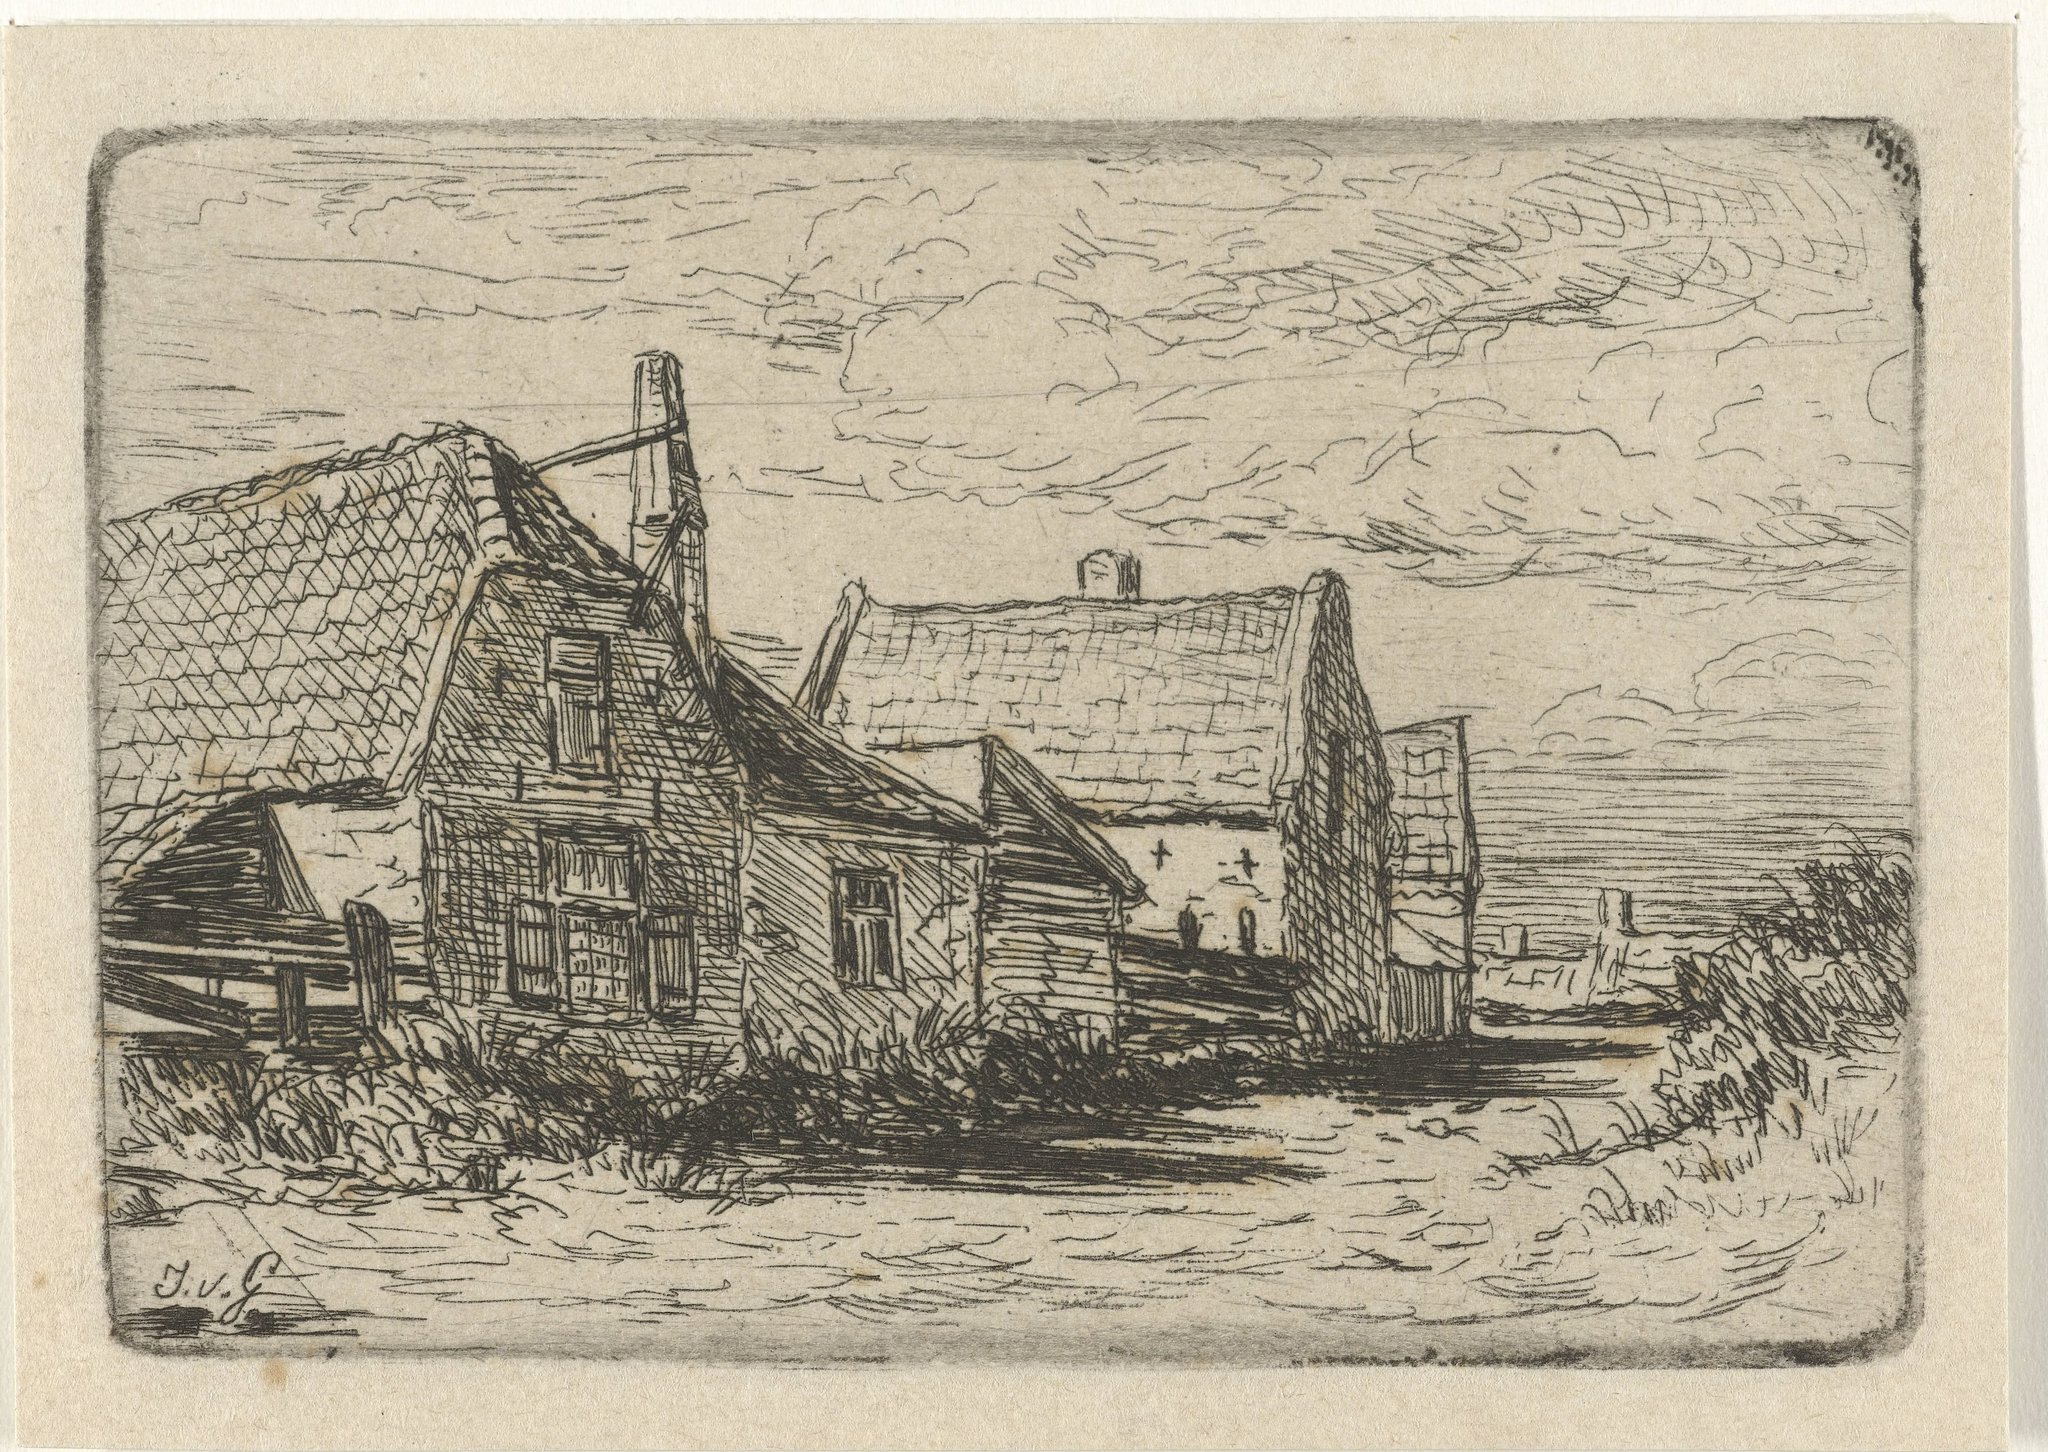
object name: print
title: Weg door het dorpje Scheveningen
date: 1837-1880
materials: paper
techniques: etching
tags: public road in village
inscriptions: collector's mark: Lugt 2228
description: Een openbare weg door Scheveningen. Links enkele huizen.